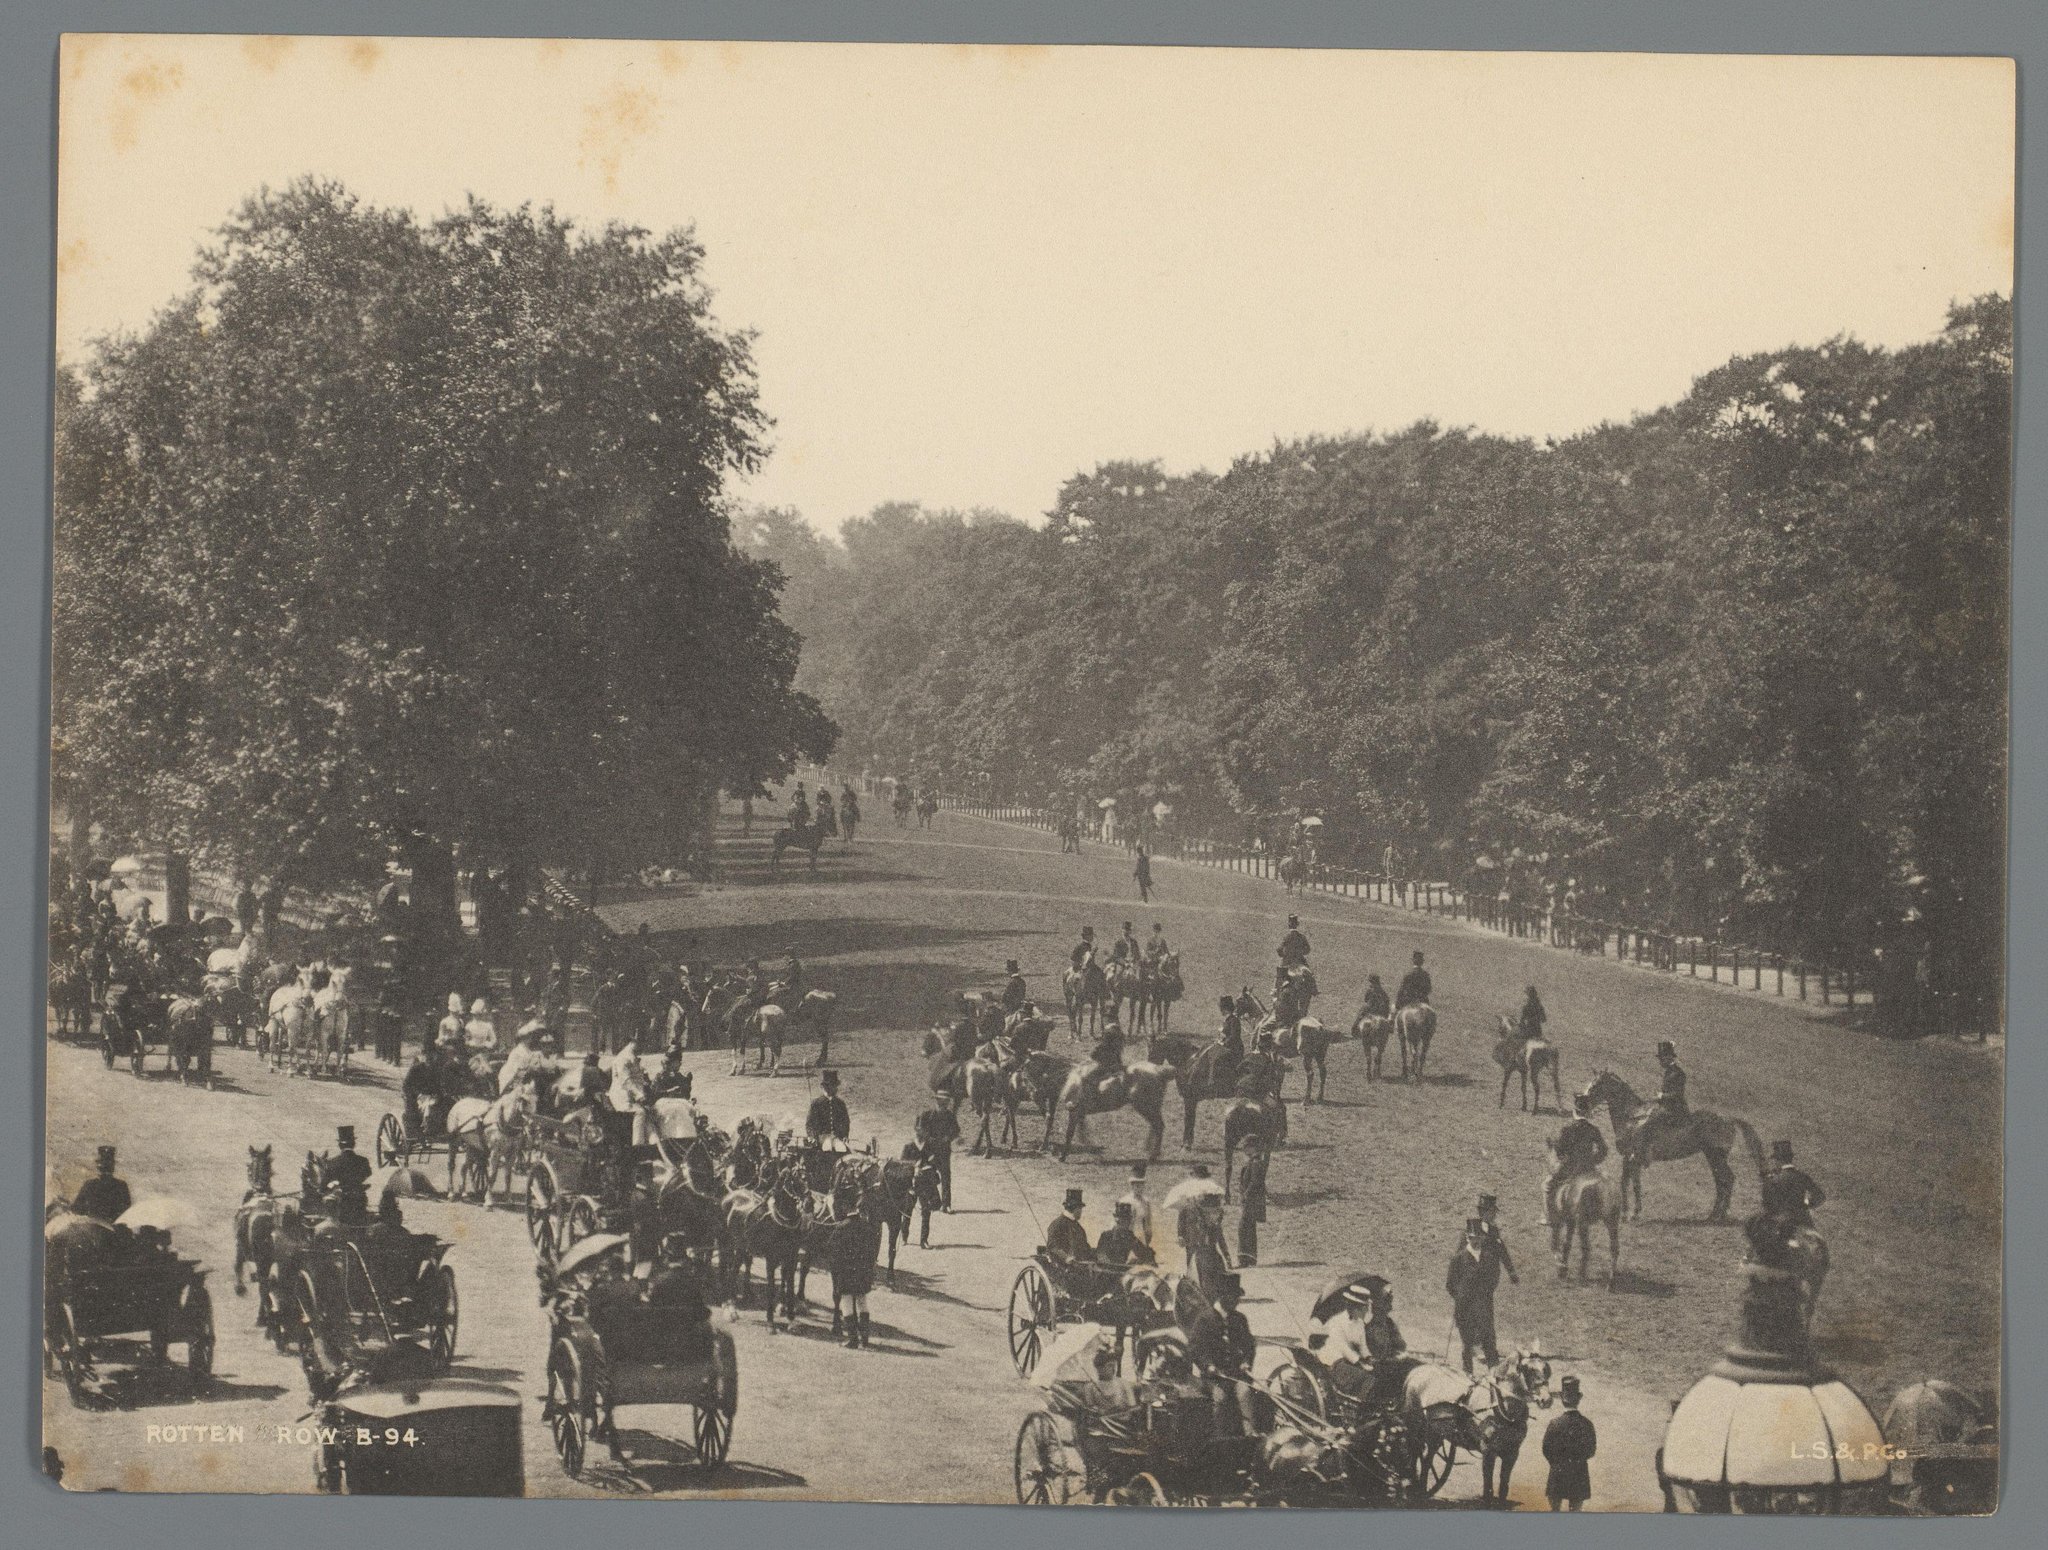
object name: photomechanical print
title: Gezicht op Rotten Row in Hyde Park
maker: Anonymous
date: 1870-1922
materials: paper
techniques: photograph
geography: london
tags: park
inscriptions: number: ‘B.-94.’